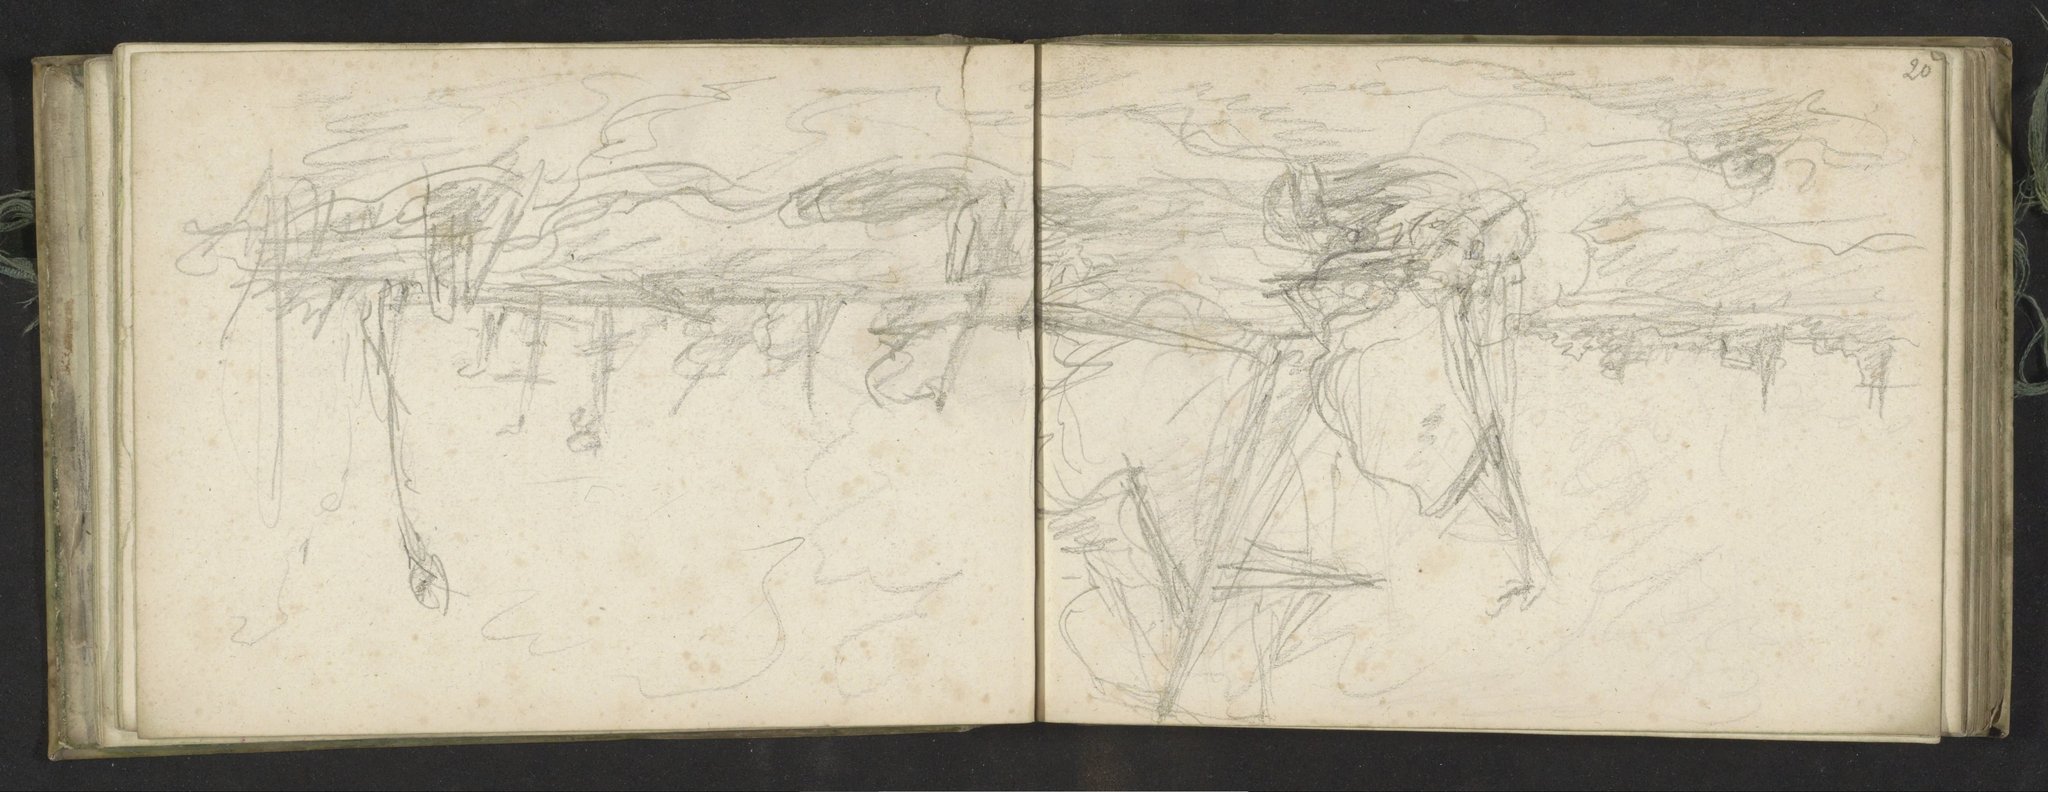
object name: sketchbook leaf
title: Zeilschepen voor een kust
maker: martinus schouman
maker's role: draughtsman, painter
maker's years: 1770-1848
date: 1780-1848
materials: paper, pencil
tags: sailing-ship, sailing-boat, coast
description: Op de achtergrond huizen en een molen. Blad 19 verso en 20 recto uit een schetsboek met 53 bladen.